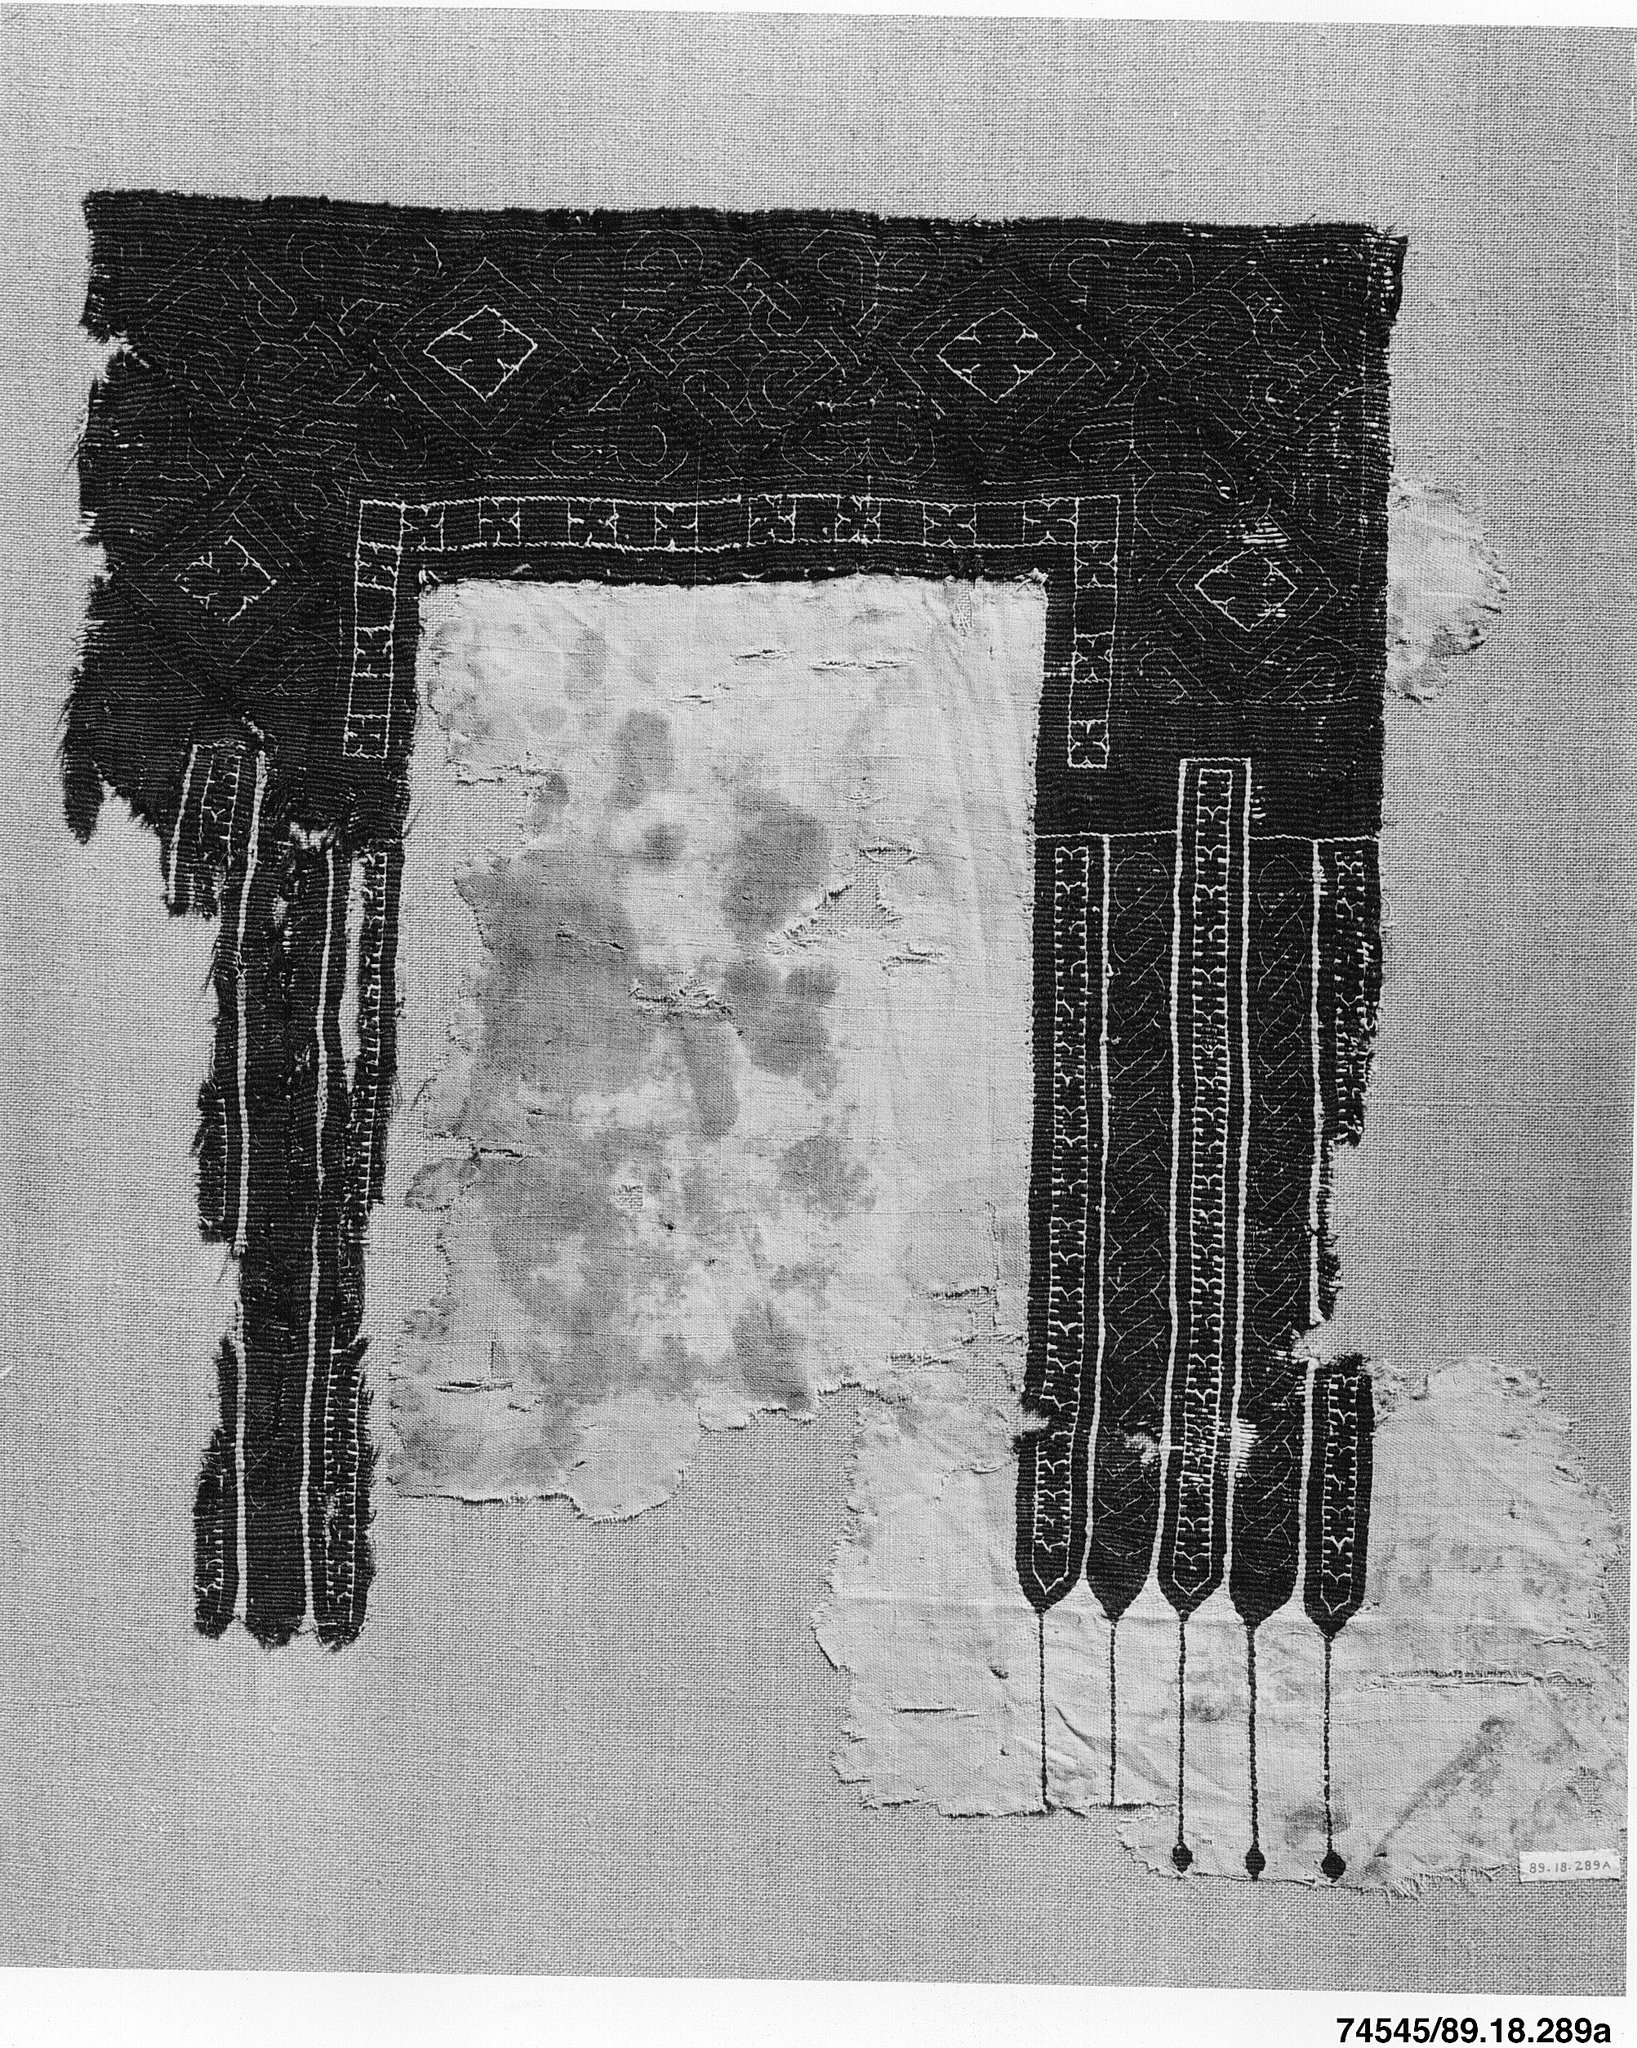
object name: textile fragment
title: Fragment of a Tunic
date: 201-400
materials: linen, wool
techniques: weave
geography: egypt